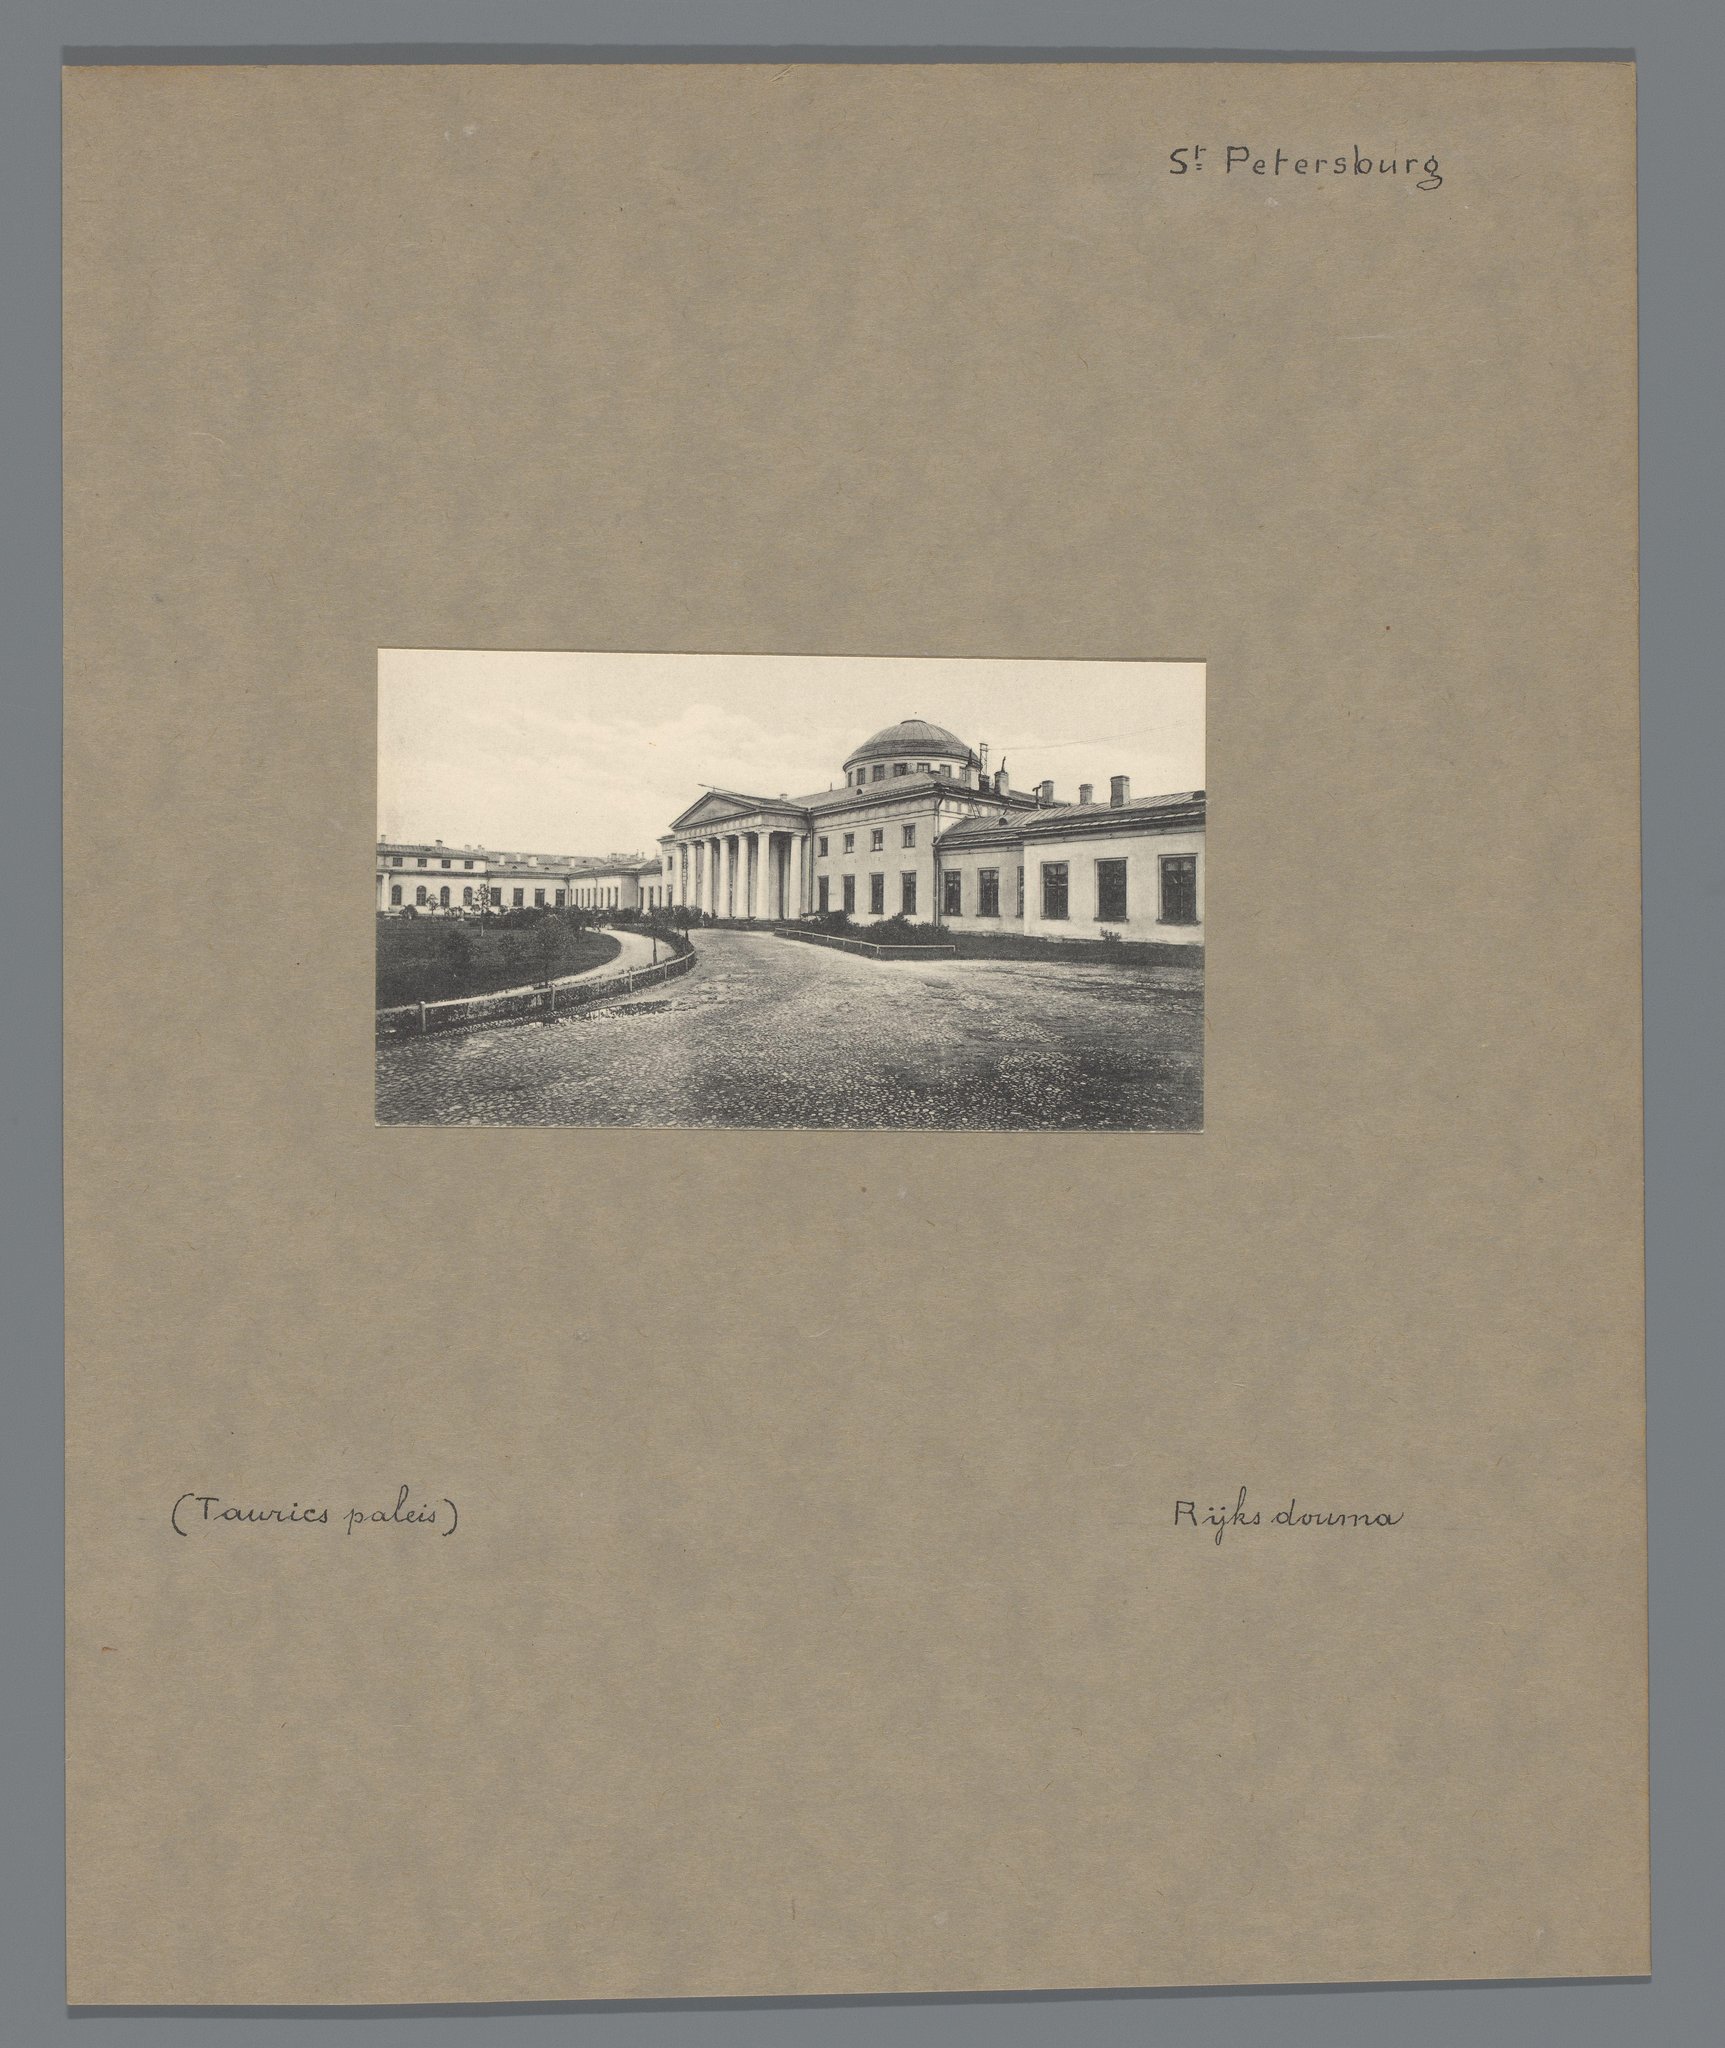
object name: photograph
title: St. Petersburg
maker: Anonymous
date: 1860-1925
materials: photographic support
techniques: photograph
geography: russia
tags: sint-petersburg